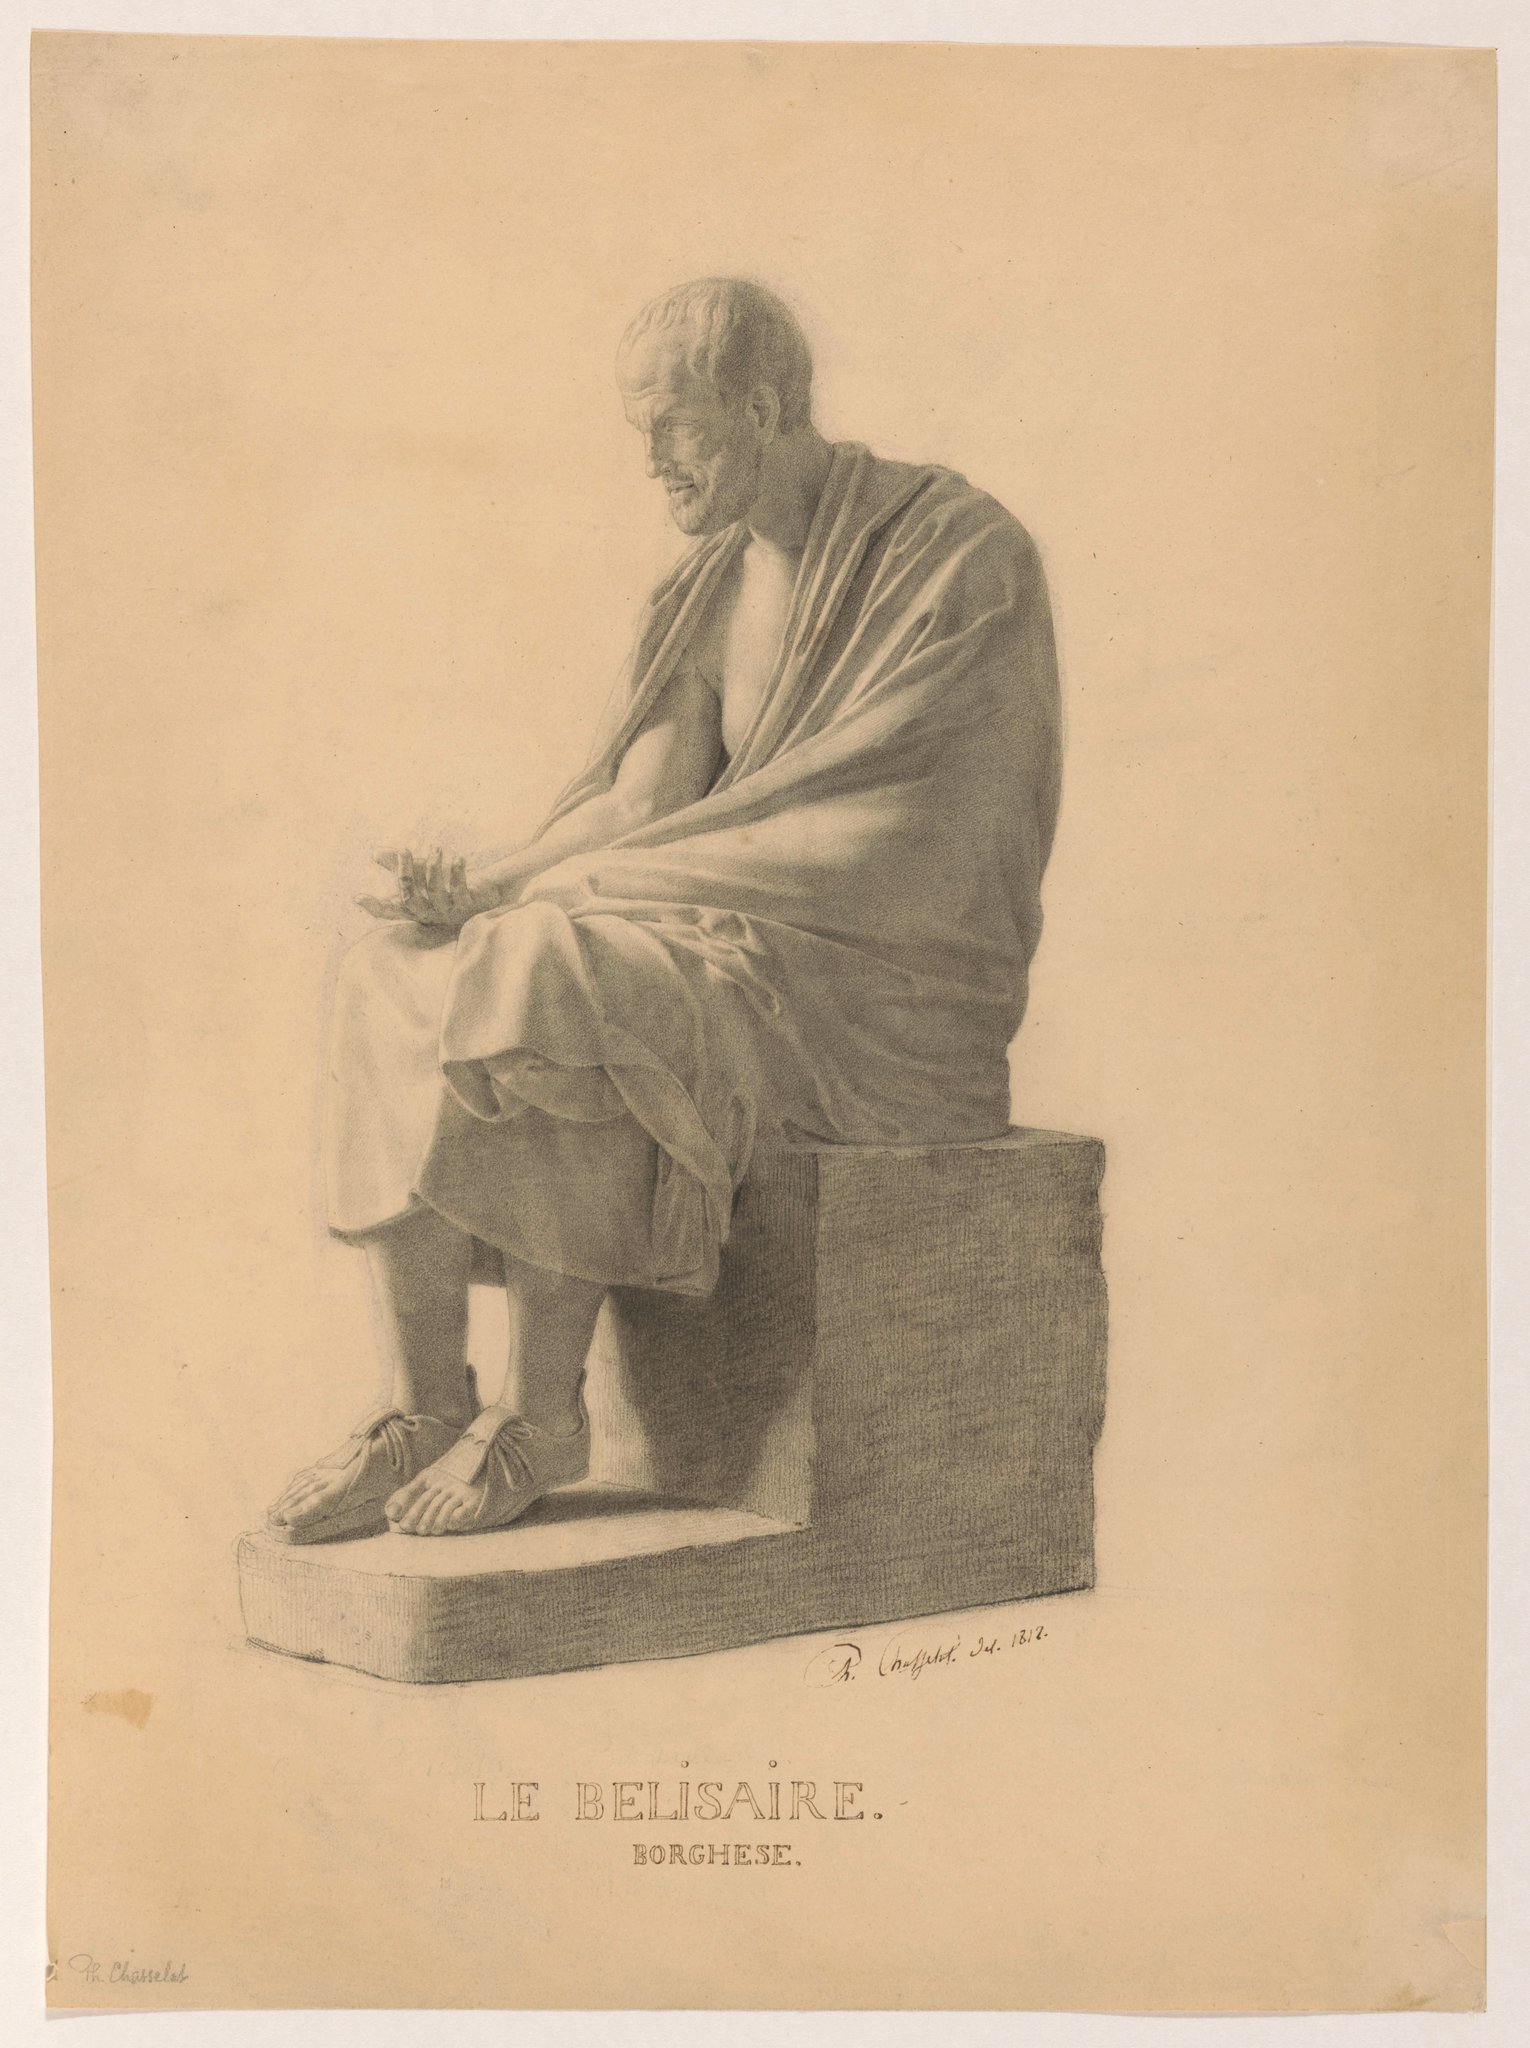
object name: drawing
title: Zittende oude man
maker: charles-abraham chasselat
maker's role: painter, print maker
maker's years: 1782-1843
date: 1812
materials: chalk, paper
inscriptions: signature and date: ‘Ch. Chasselat del. 1812.’, inscription: ‘Le Belisaire Borghese’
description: Kopie naar een antiek beeld van een zittende oude man; "Le Belisaire Borghese".